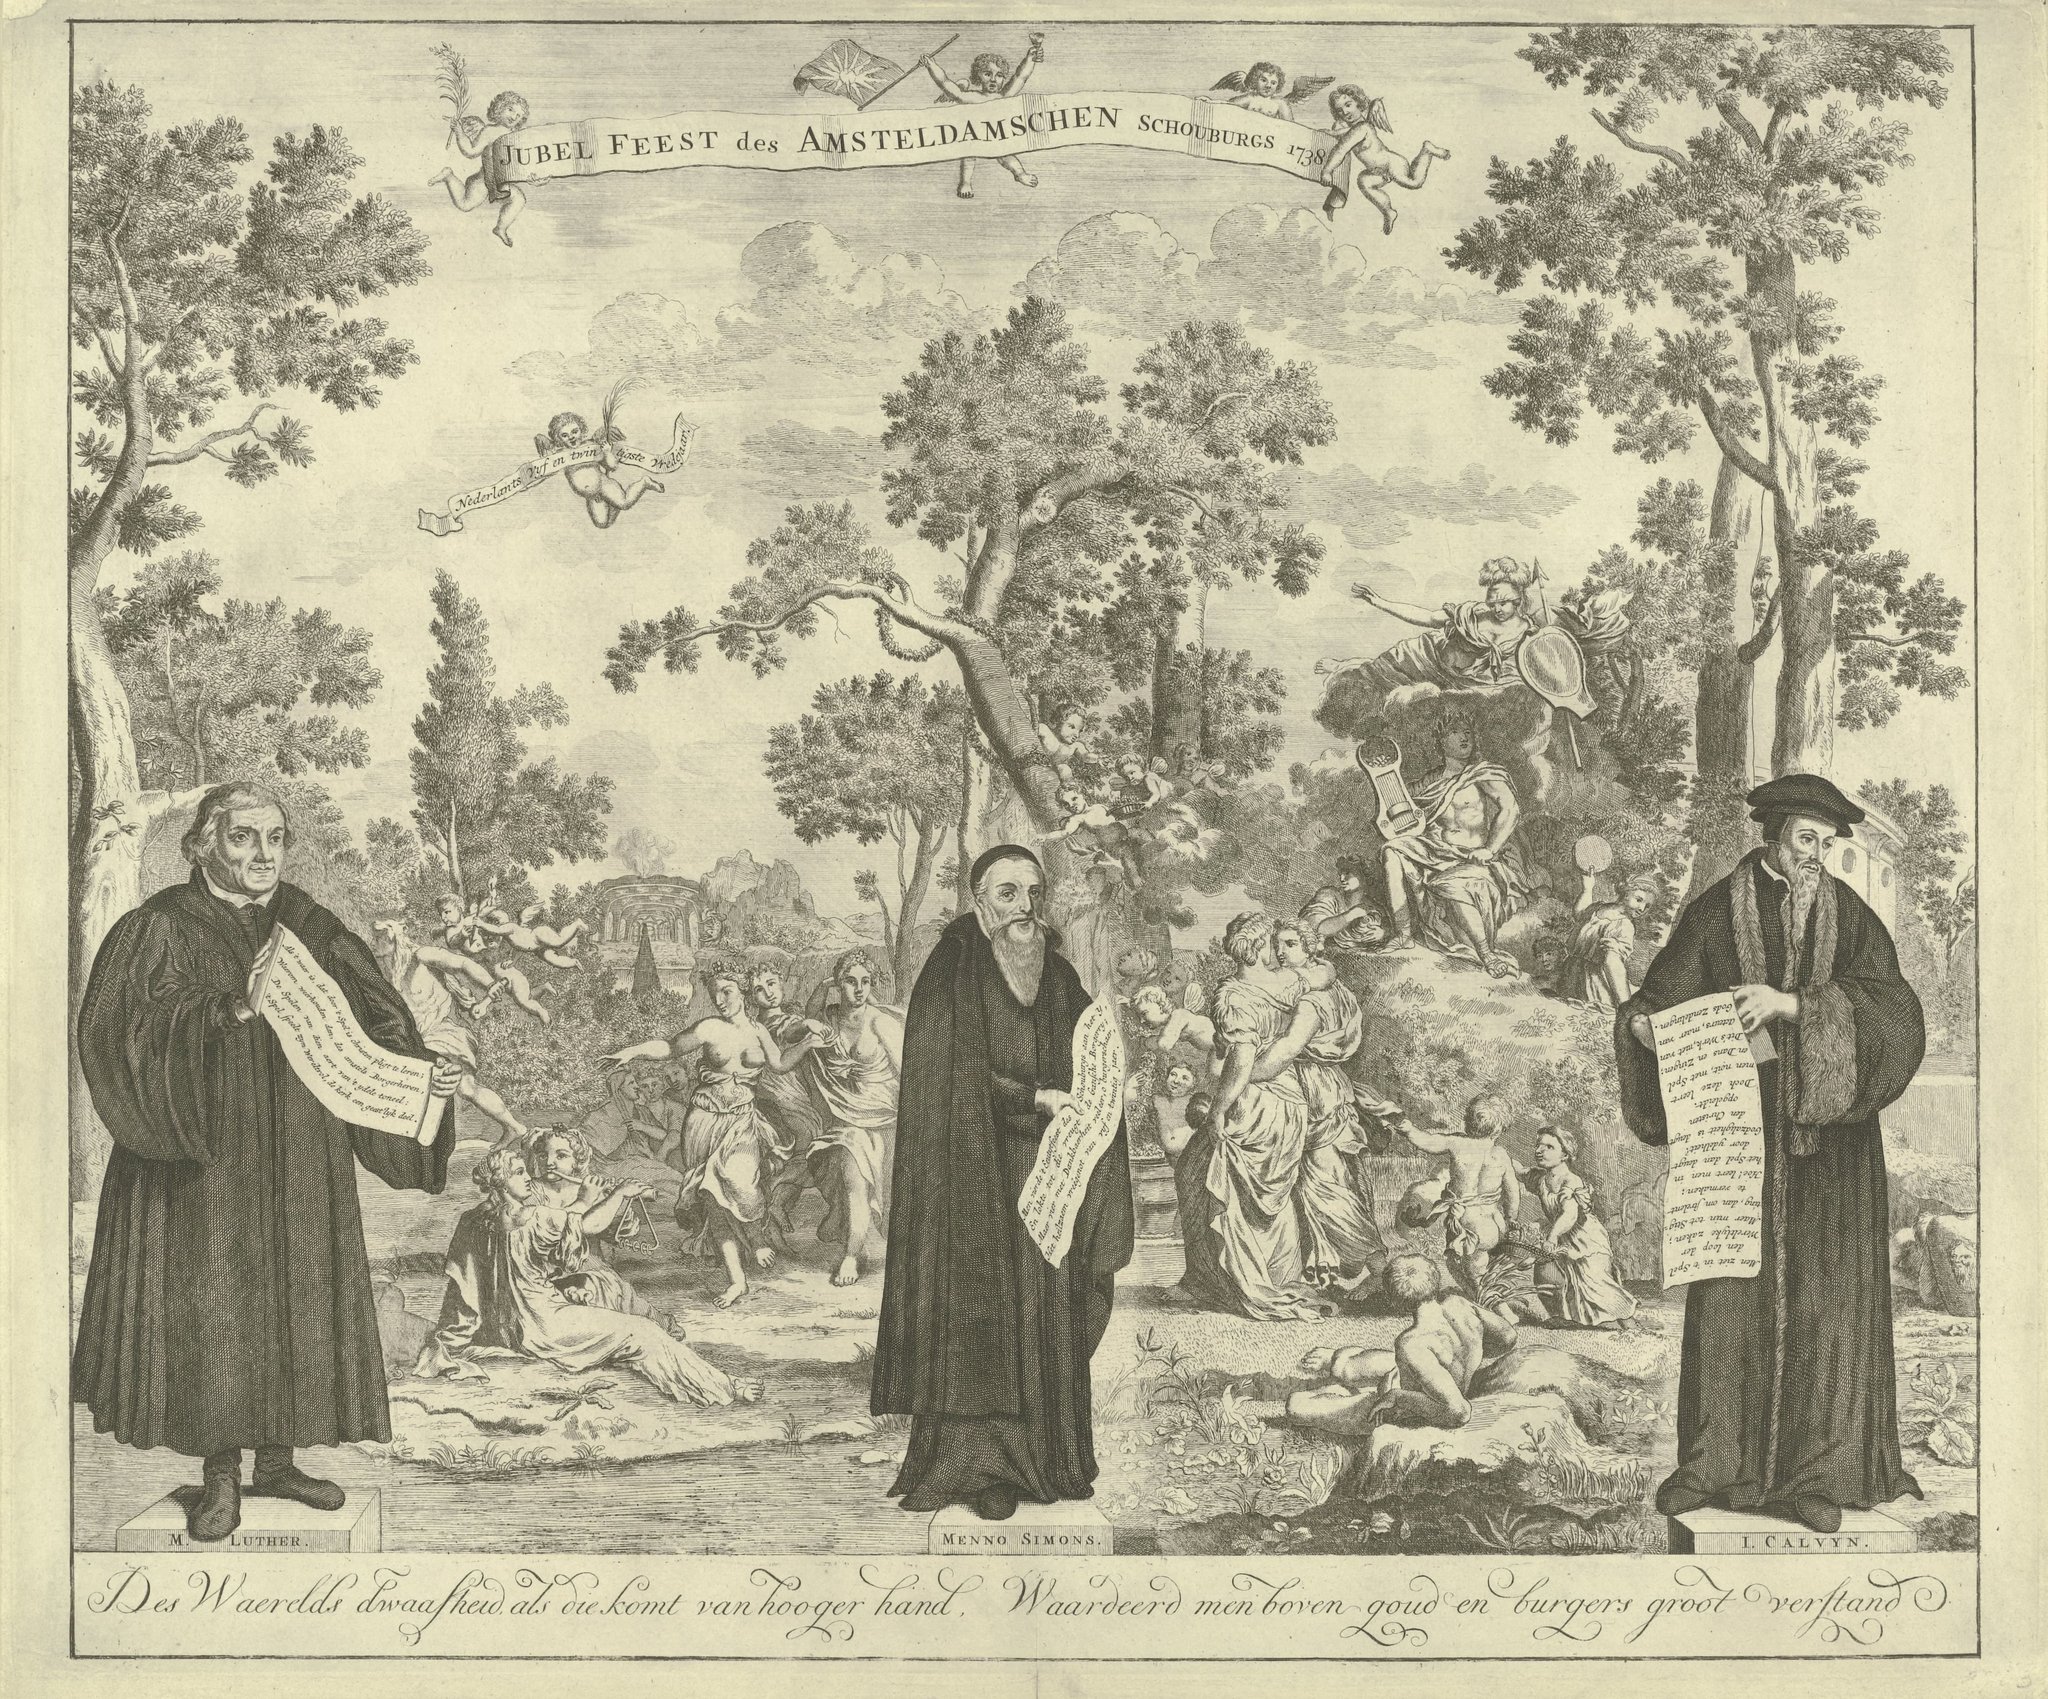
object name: print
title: Spotprent op viering van het eeuwfeest van de Amsterdamse Schouwburg, 1738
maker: Anonymous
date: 1738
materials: paper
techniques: engraving, etching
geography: northern netherlands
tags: clergyman, priest, martin luther, symbolic representations, allegories and emblems ~ the theatre, (story of) apollo (phoebus), theatre, theatrical performance, (story of) minerva (pallas, athena), gods ~ classical mythology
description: Spotprent op viering van het eerste eeuwfeest van de Amsterdamse Schouwburg aan de Keizersgracht op 7 januari 1738. Op de voorgrond staan drie protestantse kerkhervormers met teksten met kritiek op het jubileum. Links Martin Luther, in het midden Menno Simons en rechts Johannes Calvijn. De tekst van Menno Simons roept op dat het beter zou zijn om het 25-jarige jubileum van de Vrede van Utrecht (1713) te vieren. Op de achtergrond een toneelstuk met een arcadisch landschap met Apollo en andere mythologische figuren, putti, nimfen etc.